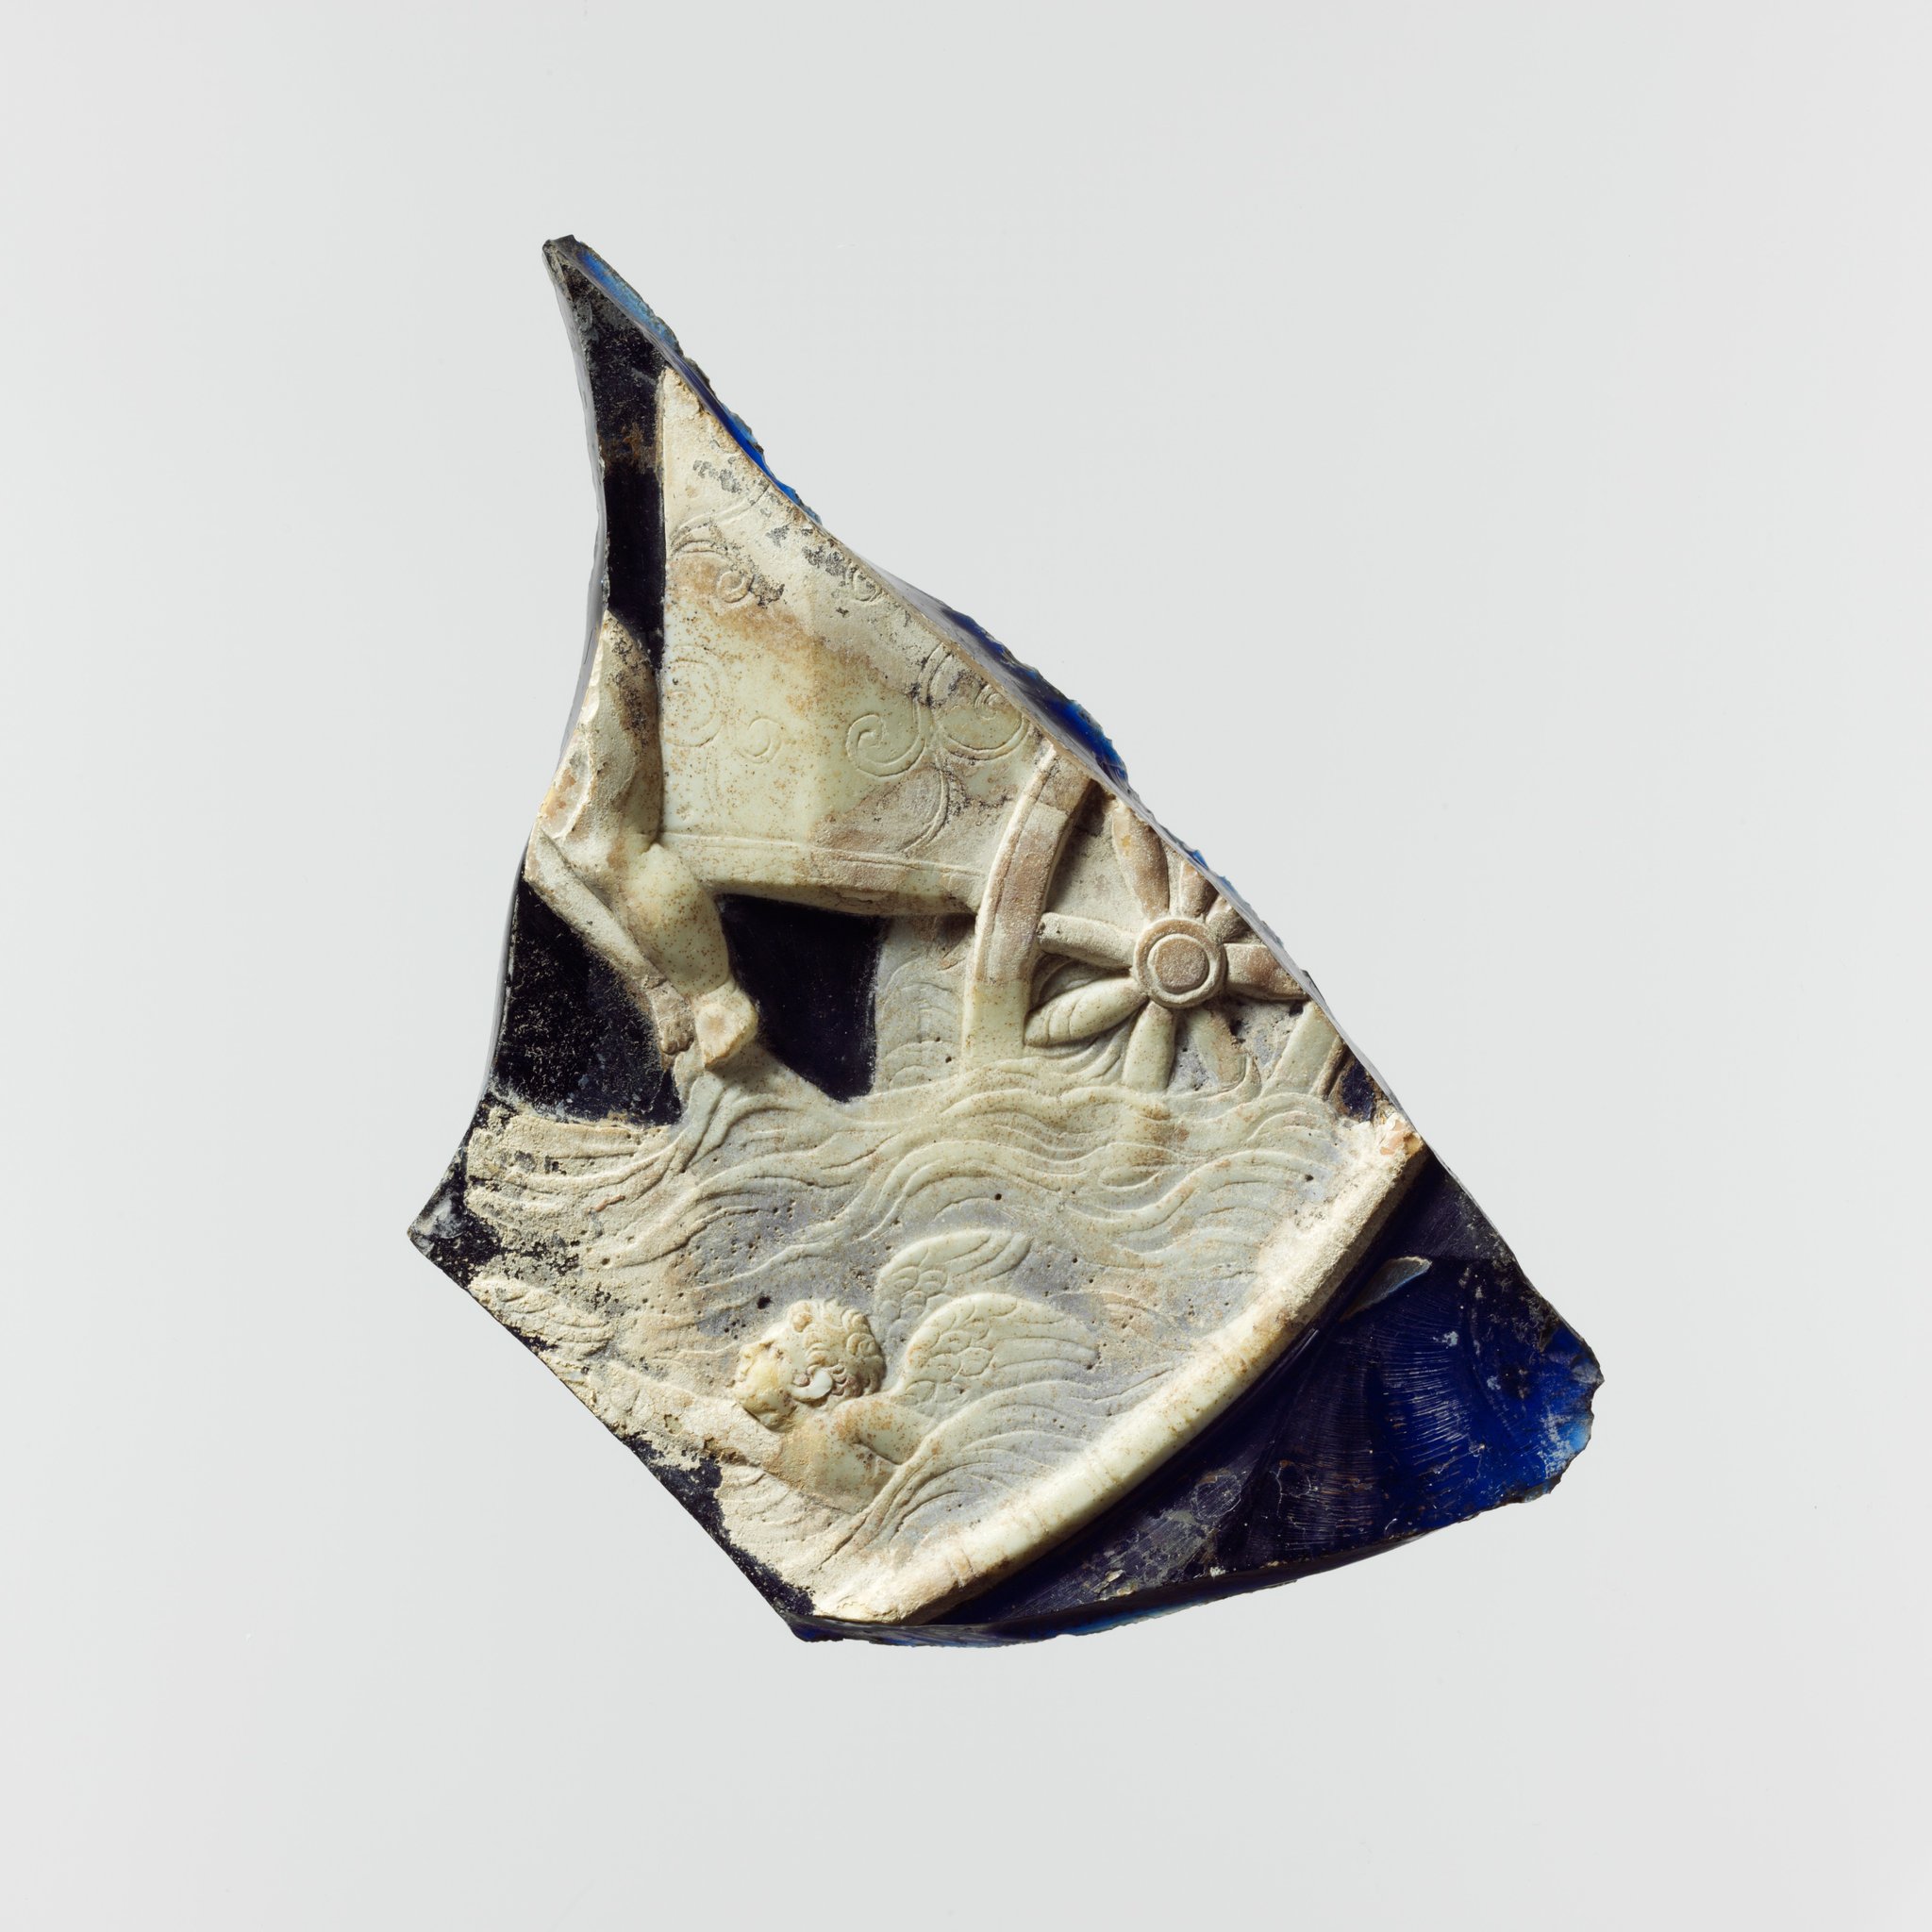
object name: cameo, fragment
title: Glass cameo plate fragment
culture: roman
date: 1-100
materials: glass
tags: cupid,chariots